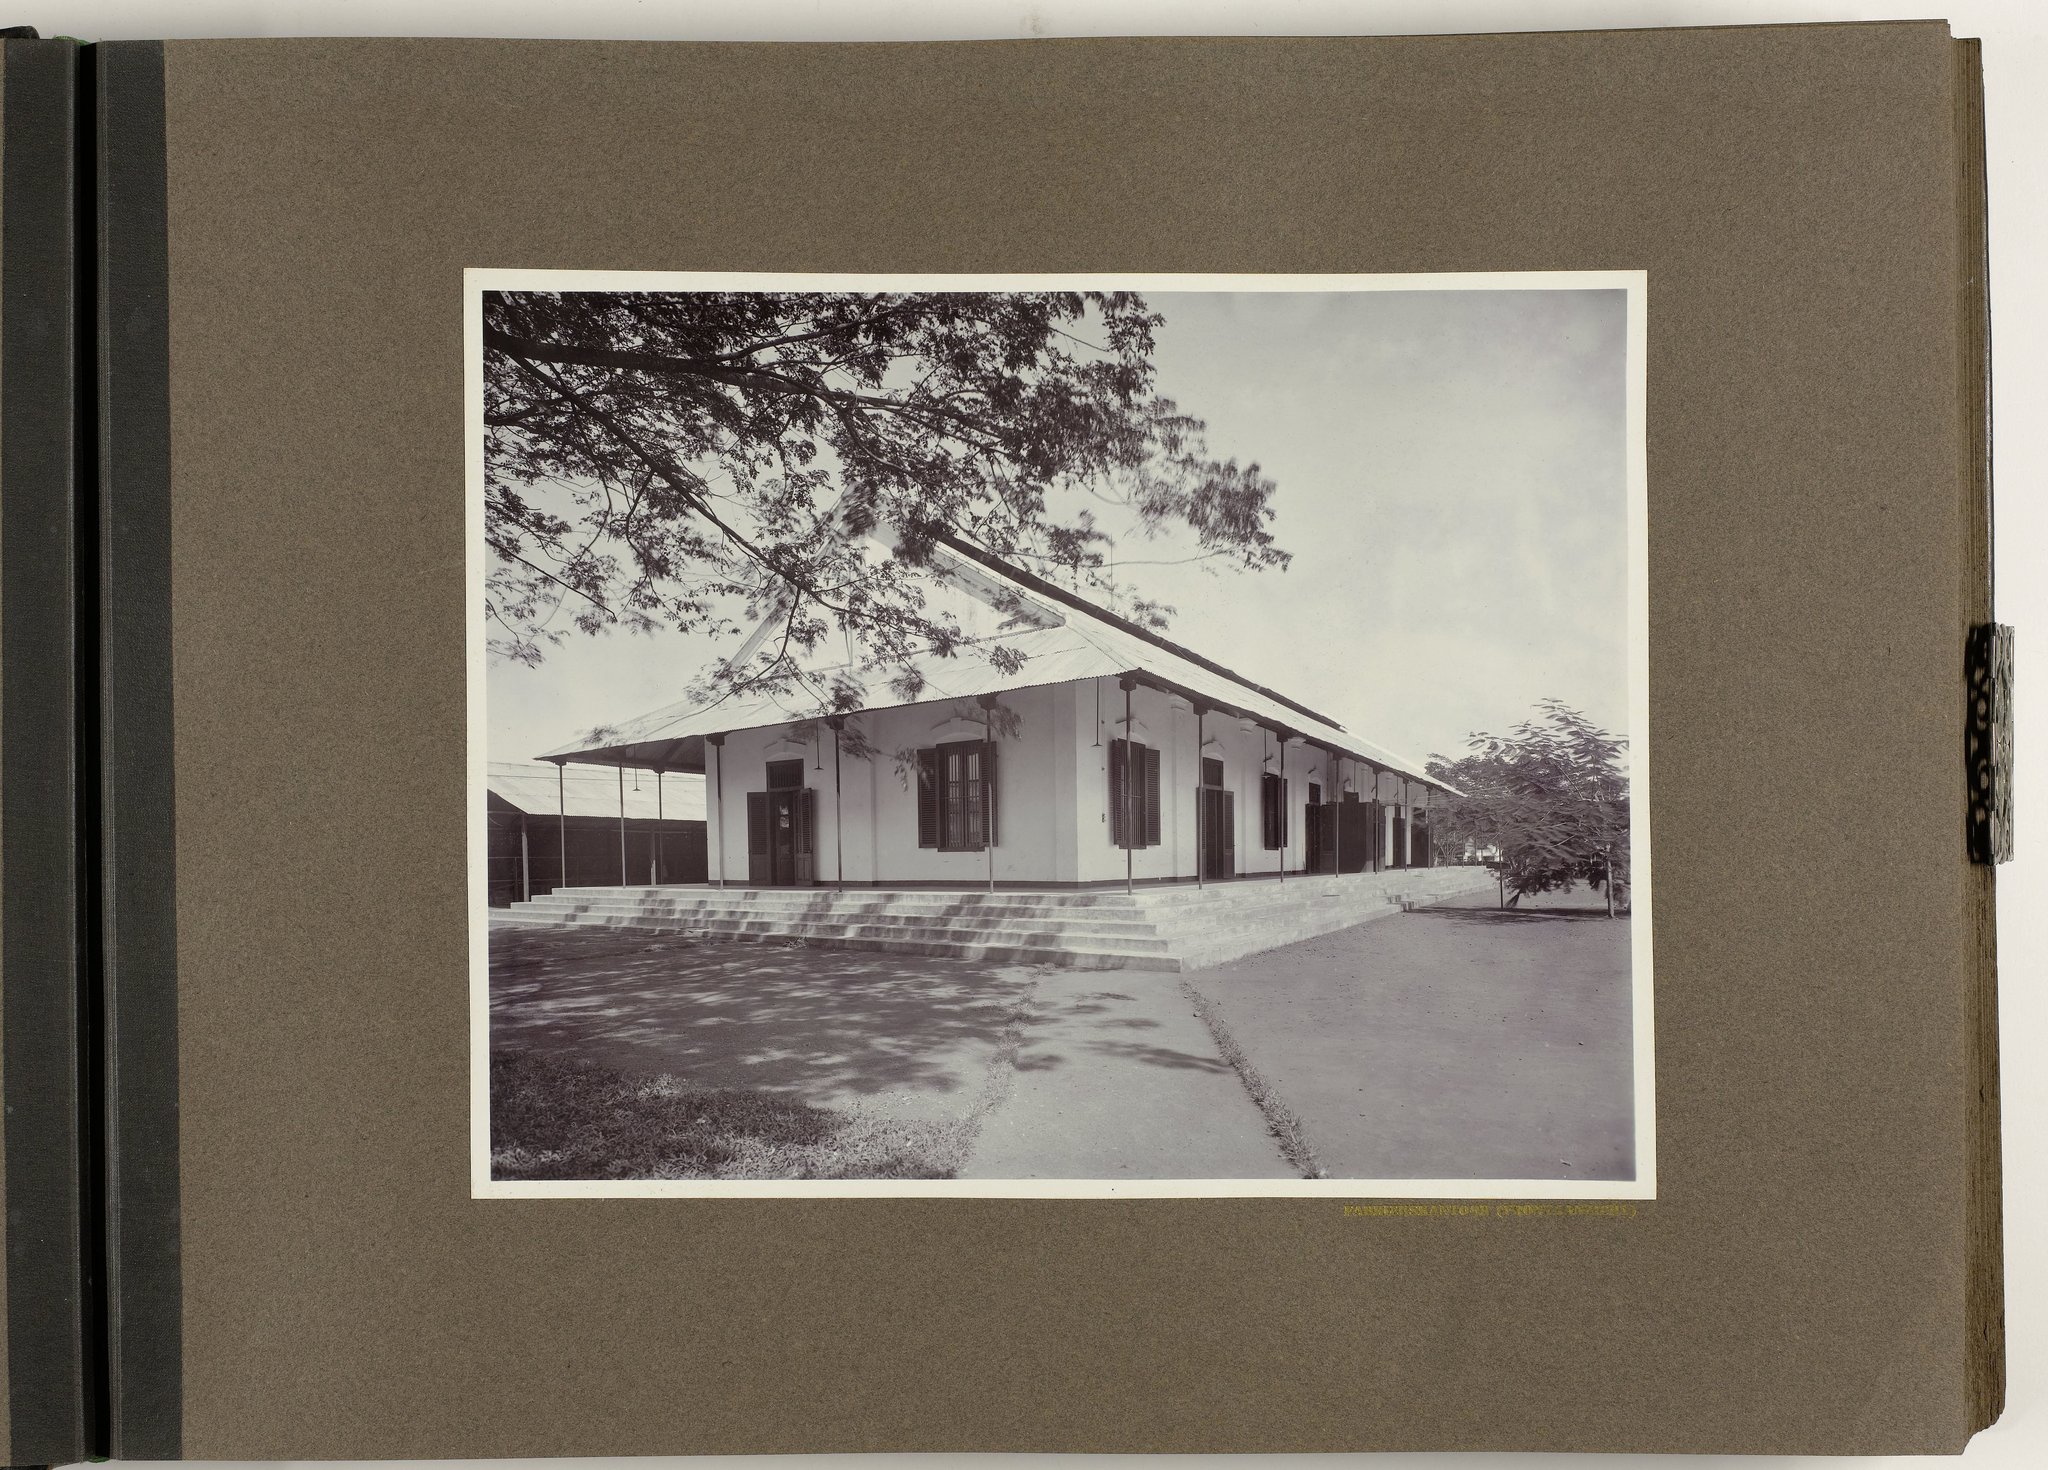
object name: photograph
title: Fabriekskantoor (frontaanzicht)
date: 1917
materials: photographic support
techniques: gelatin silver print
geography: jatiroto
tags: colonial system, (non-fruit) products of plants or trees: sugarcane, exterior of industrial structures, factories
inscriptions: inscription: ‘FABRIEKSKANTOOR (FRONTAANZICHT)’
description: Kantoorgebouw van de suikerfabriek. Wit gebouw met overhangend dak en opengeslagen luiken voor de ramen en deuren. Voor de ramen zitten tralies. Om het pand traptreden. Onderdeel van het fotoalbum aangeboden aan F.J. Wirix door het personeel van de Suikeronderneming Djatiroto in 1917.